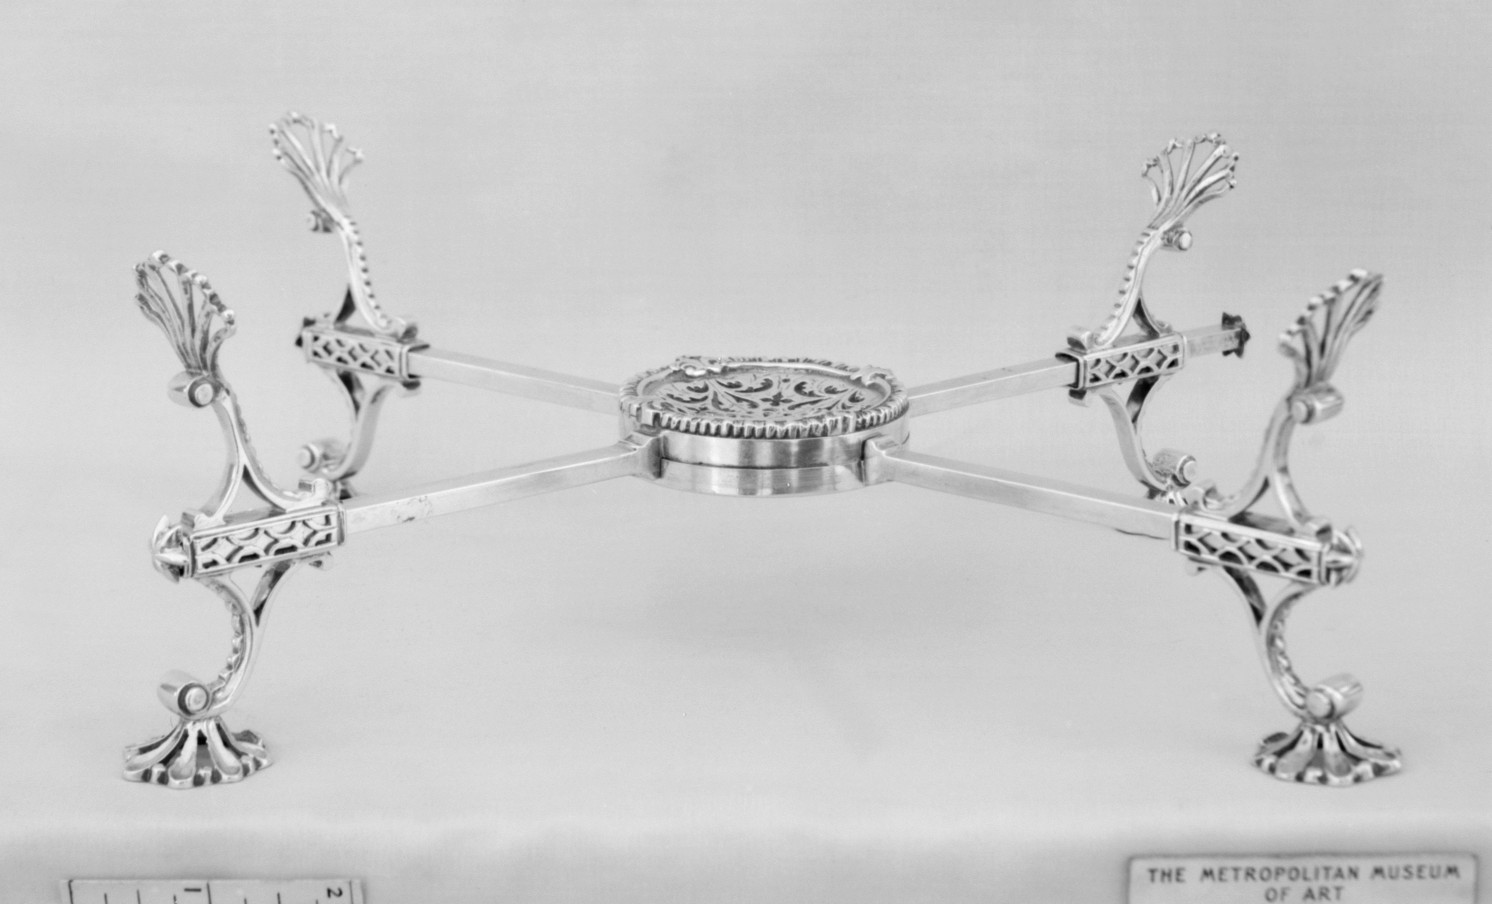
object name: dish cross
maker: samuel herbert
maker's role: maker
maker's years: 1747-1773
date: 1764-1765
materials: silver